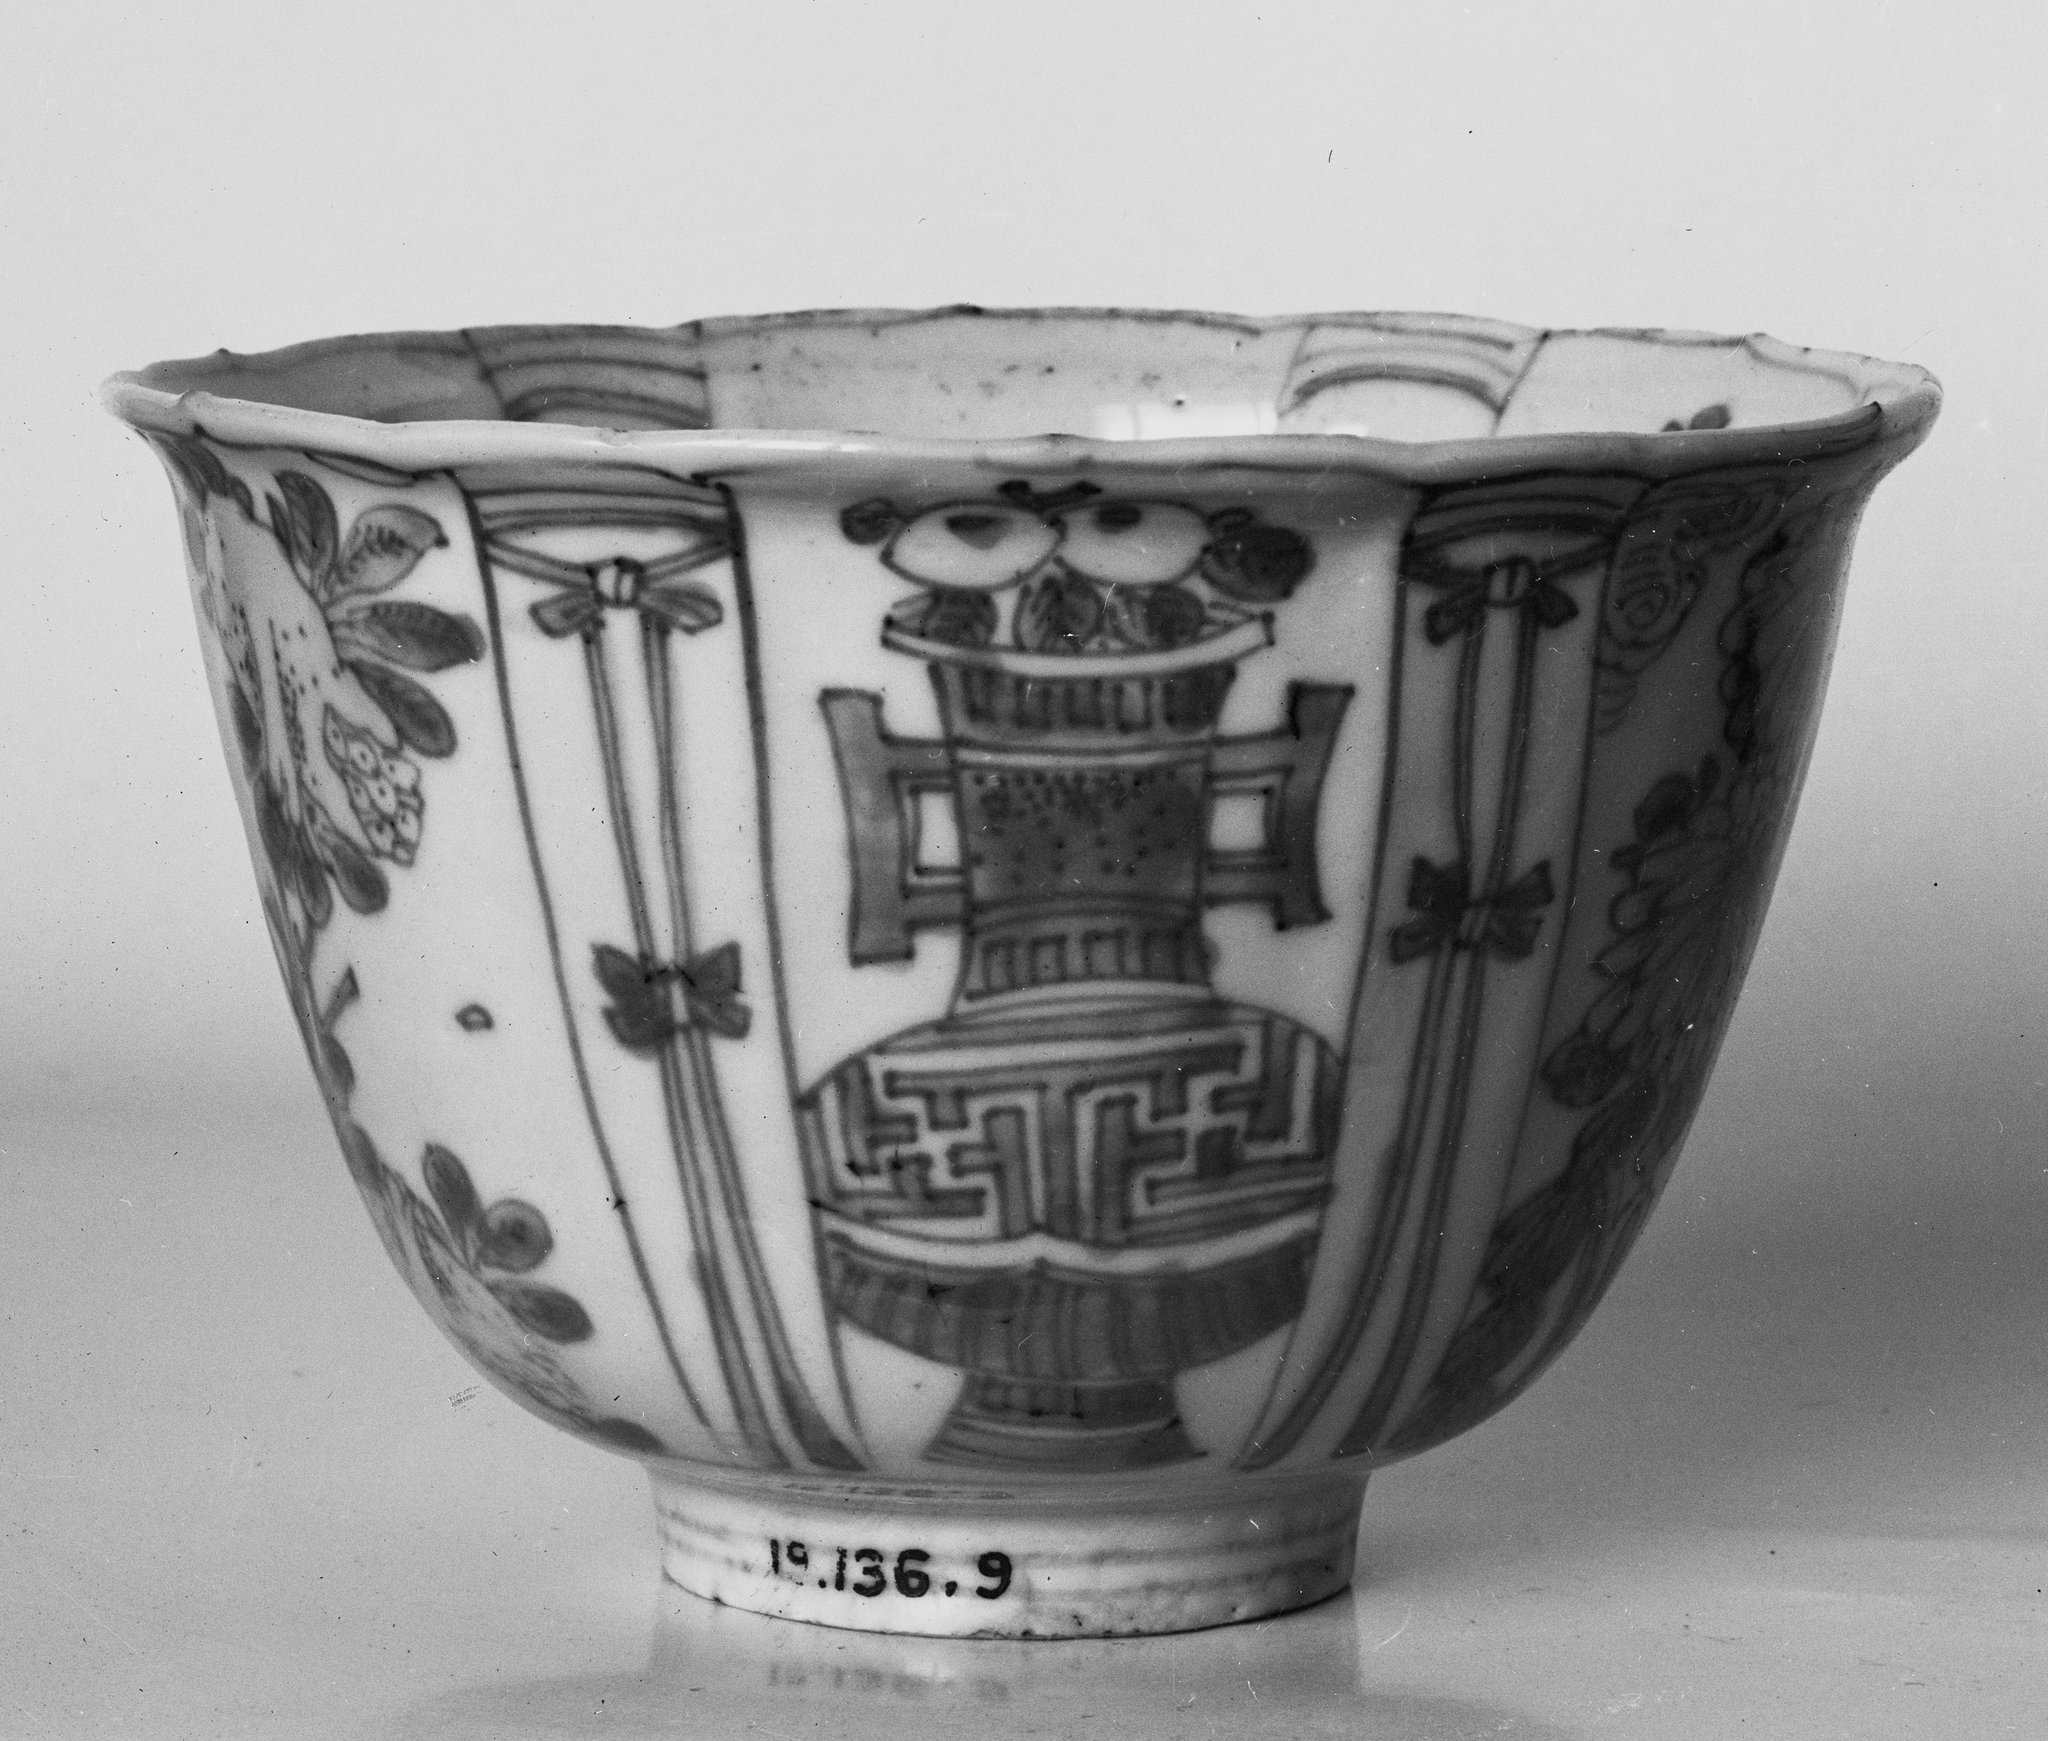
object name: cup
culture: chinese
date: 1600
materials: porcelain